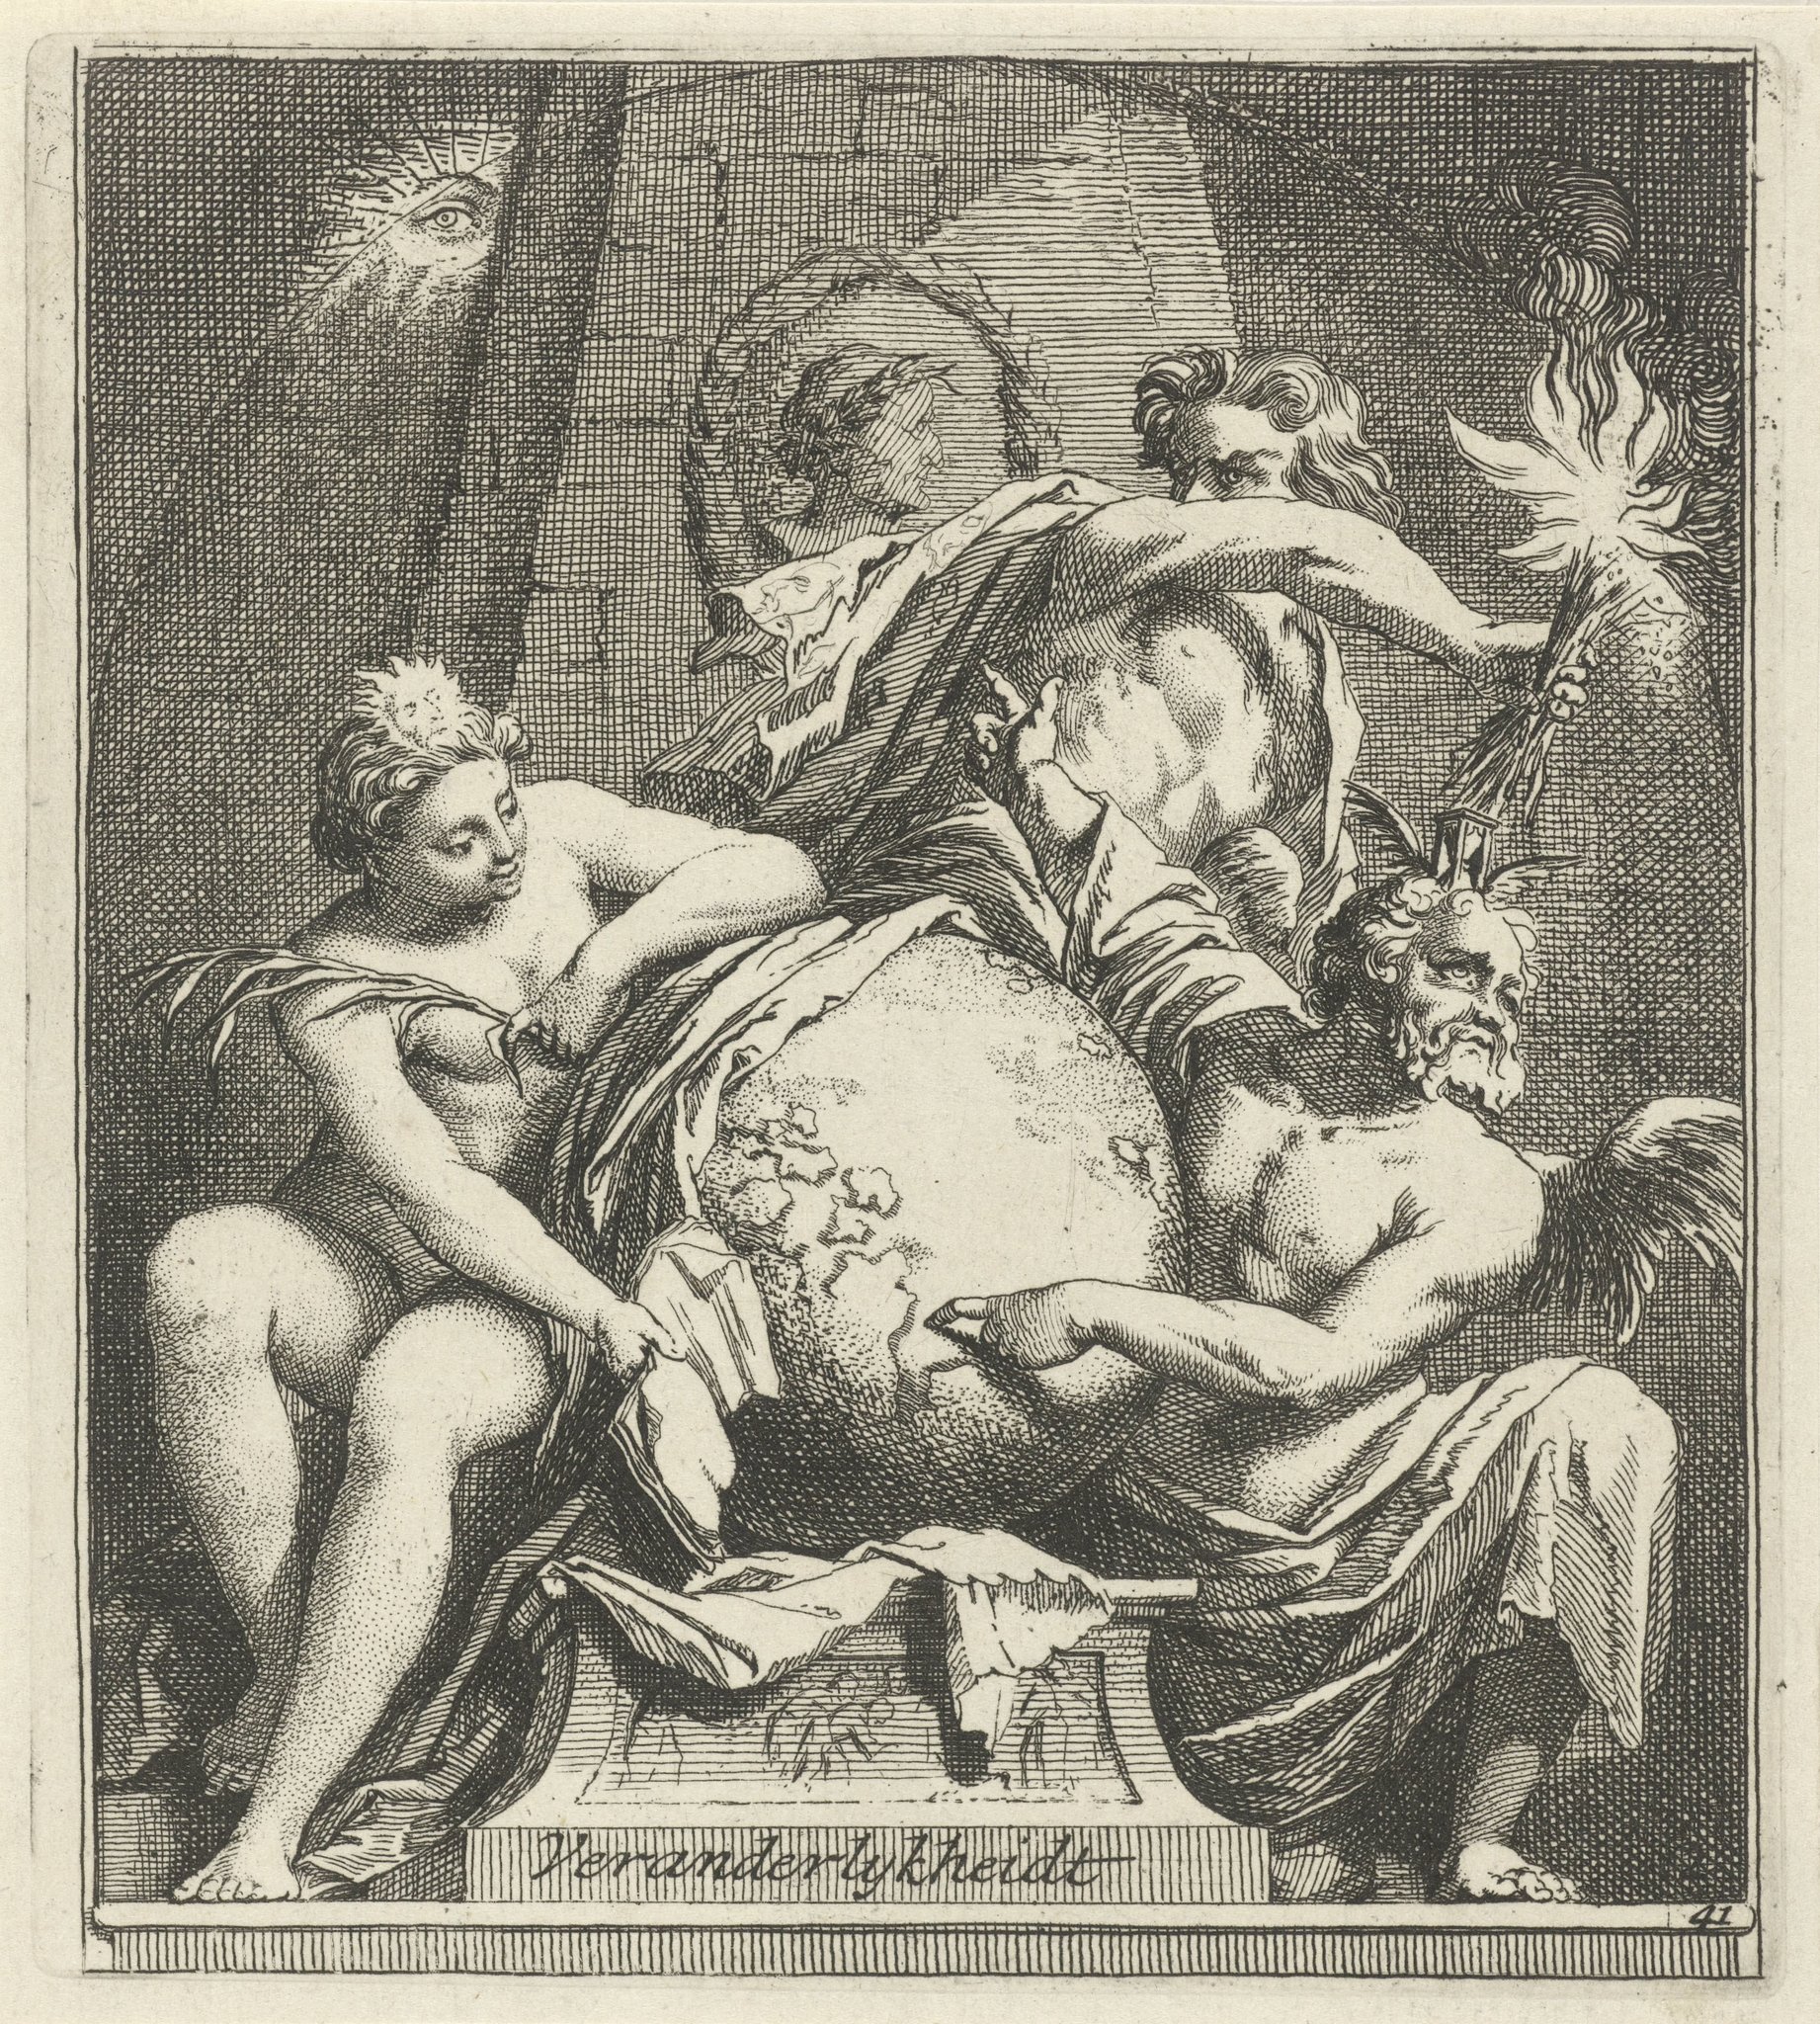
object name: print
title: Een-en-veertigh stuks, verscheydene Sinnebeelden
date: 1710-1719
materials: paper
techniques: engraving, etching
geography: amsterdam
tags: the all-seeing eye, triangle with eye ~ symbol of god the father, globe, father time, man with wings and scythe, change (+ allegorical scene, i.e. two or more personifications involved in an action), truth; 'verità' (ripa) (+ nude)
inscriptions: collector's mark: Lugt 2228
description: Allegorische voorstelling met een wereldbol, op een piëdestal met een bas-reliëf, die wordt geflankeerd door Vader Tijd (rechts), met op zijn hoofd een zandloper en vleugels op zijn rug en de gepersonifieerde Waarheid (links), met op haar hoofd een zon. Vader Tijd wijst met een hand op de wereldbol met met zijn andere op een Alziend oog linksboven in de achtergrond. Achter de wereldbol een derde figuur, de personificatie van de leugen, die zich afwendt met een brandende bos takken in zijn hand. Prent uit een serie van 41 zinnebeelden.